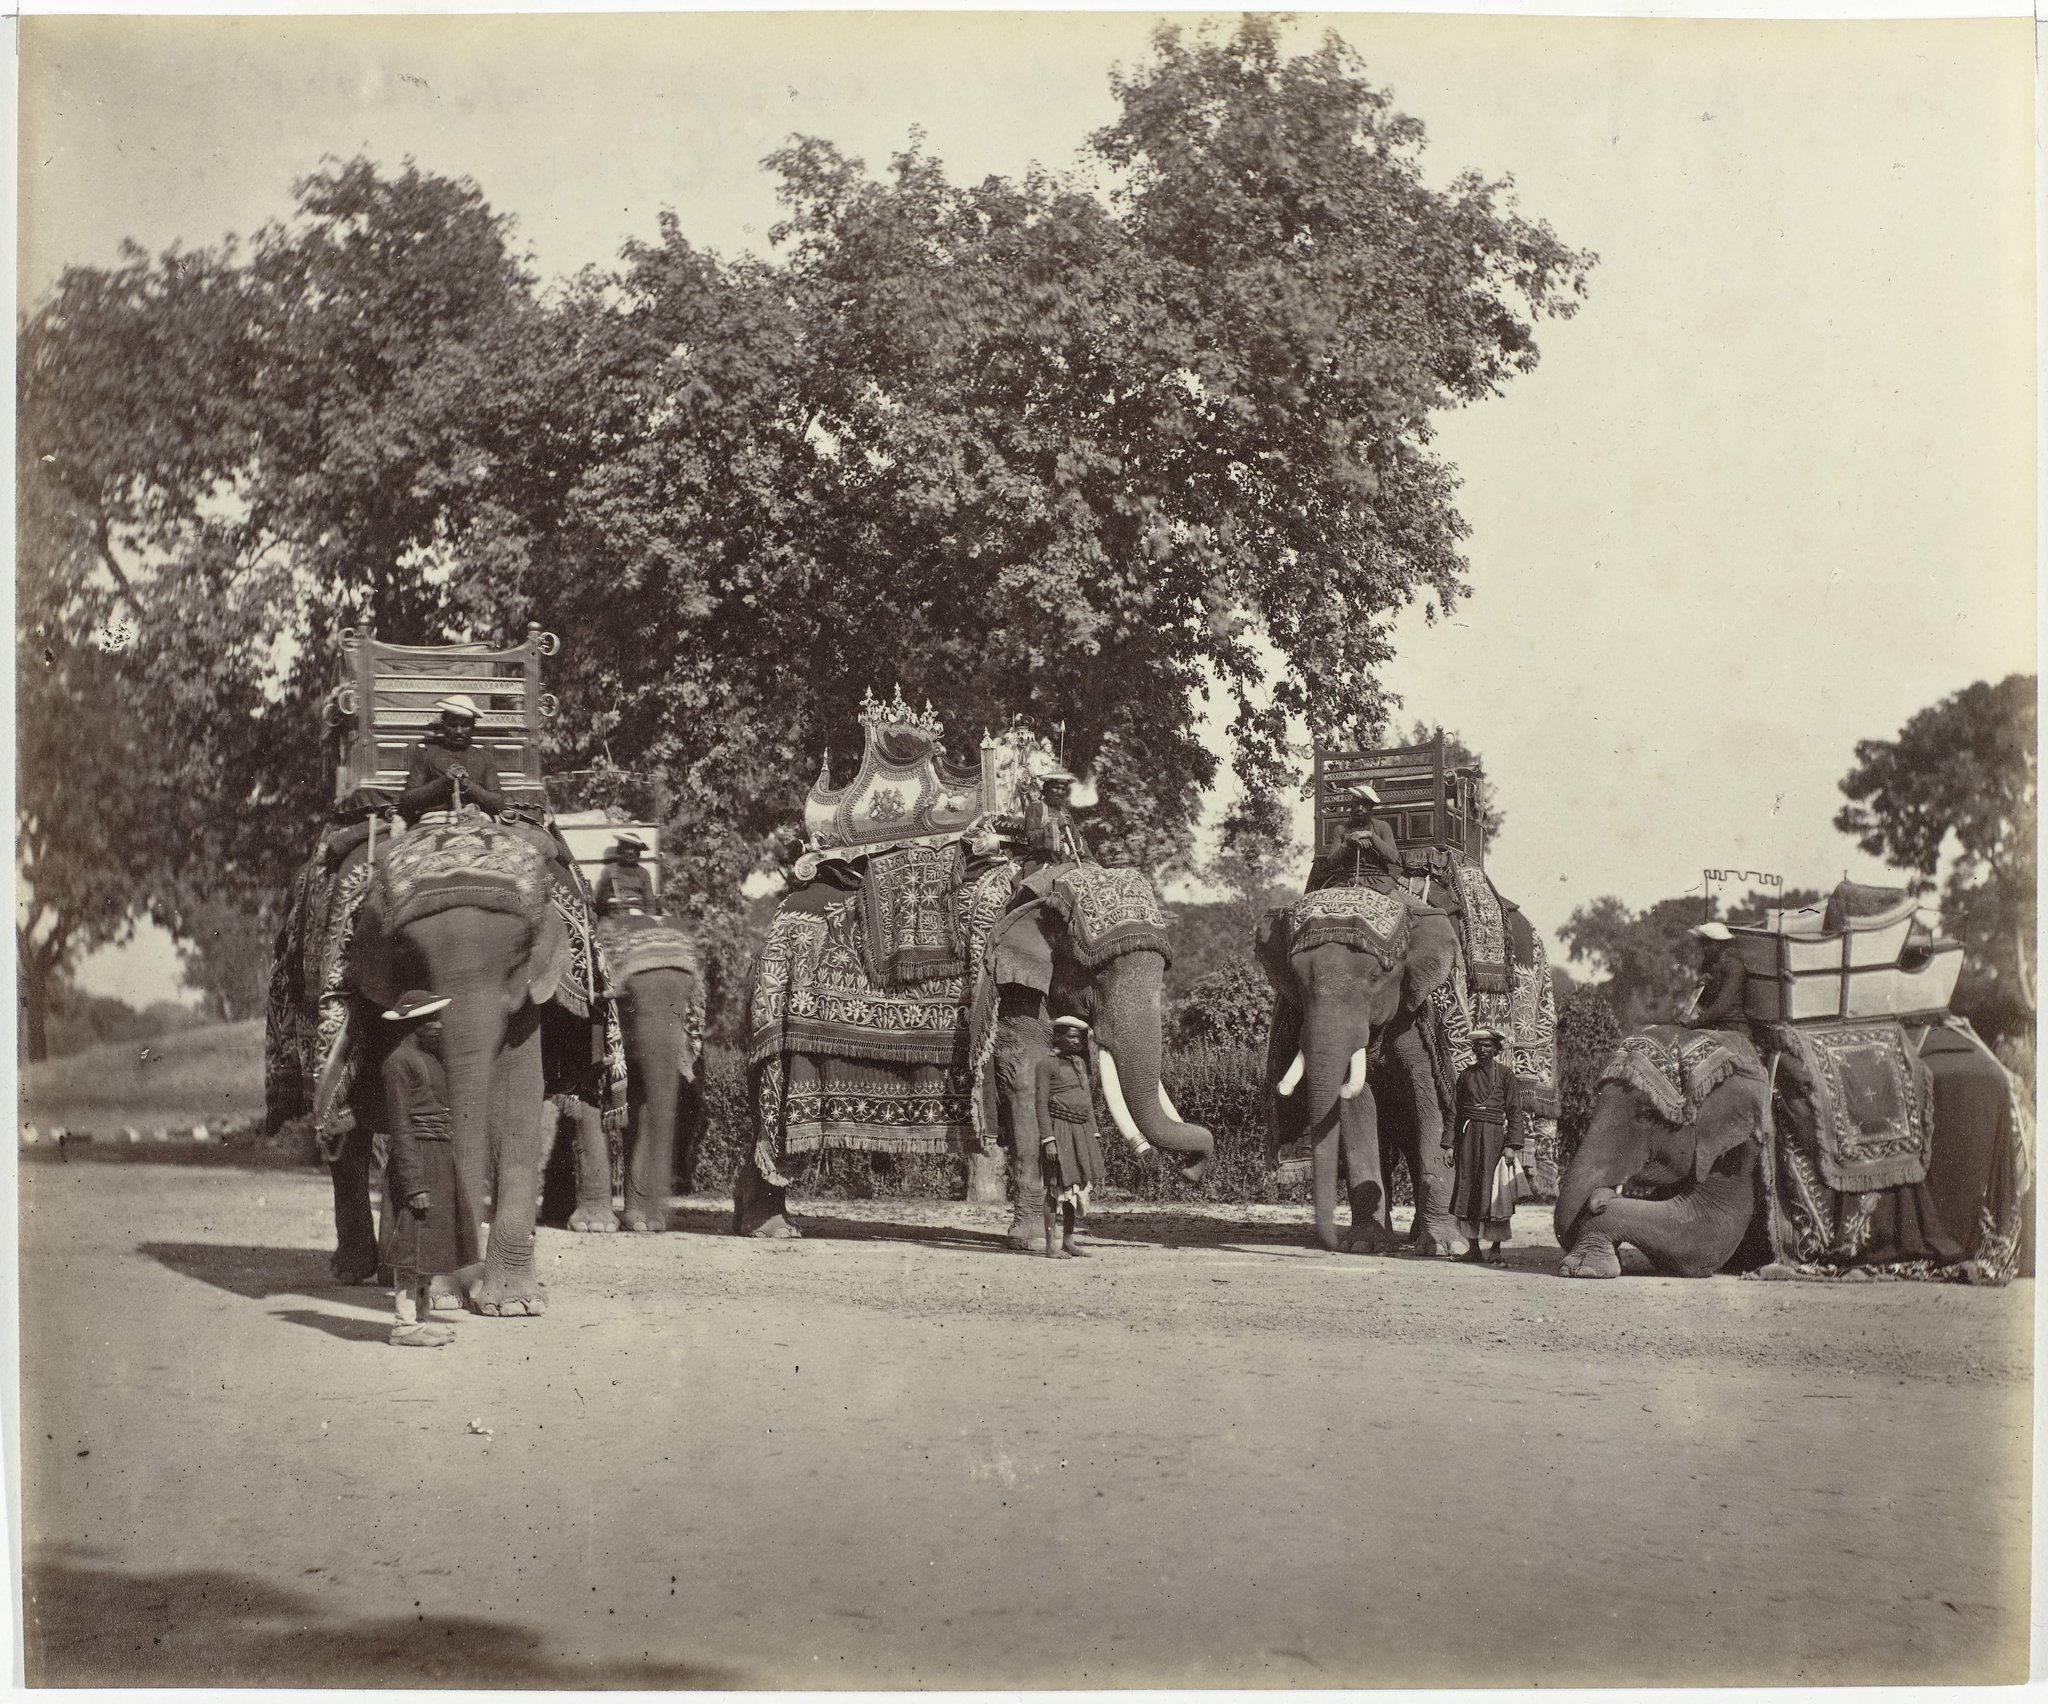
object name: photograph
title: Caparisoned viceroyal elephants, Varanasi (Benares), Uttar Pradesh, India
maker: samuel bourne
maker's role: fotograaf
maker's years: 1834-1912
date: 1865-1866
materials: paper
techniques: albumen print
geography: varanasi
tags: trunked animals: elephant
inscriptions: inscription: ‘A group of H. E. the Viceroy's Elephants/ with their state wrappings/ most probably by Bourne/ ±1870/ f200,-/ 1132D/ 56/ 1258’